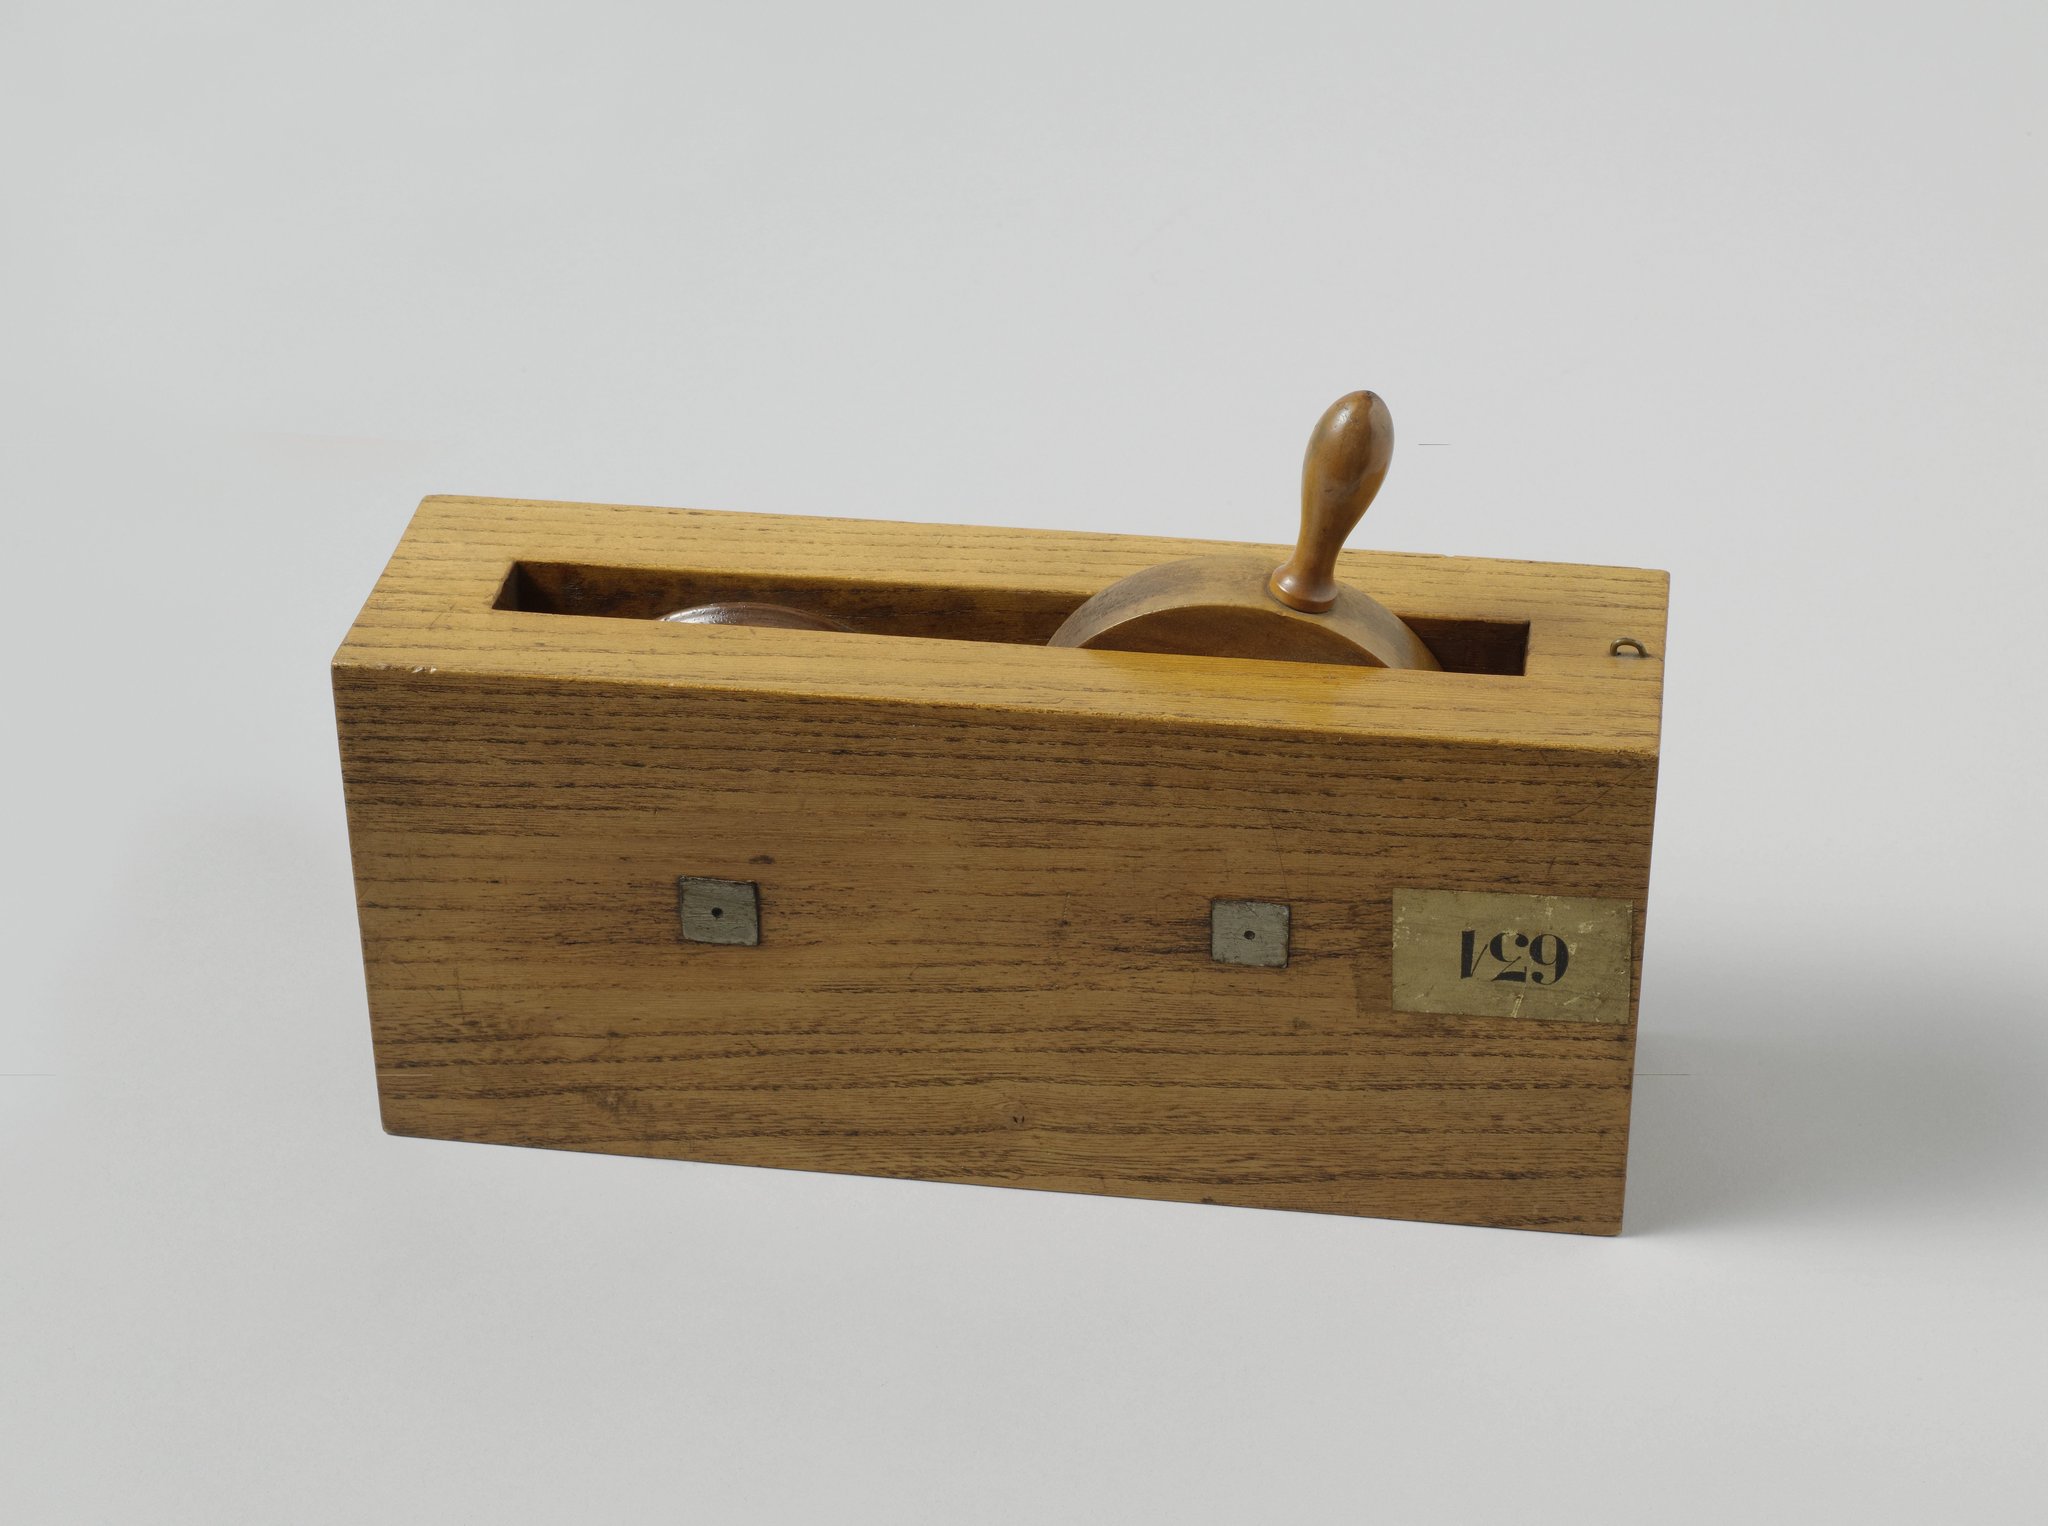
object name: demonstration model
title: Model of an Eccentric Stopper for Sheets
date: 1856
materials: iron, wood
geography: amsterdam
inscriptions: label: ‘631’ former inventory label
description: Model van een excentrieke stopper voor zeilschoten, bestaande uit twee schijven in een houten blok. Een van de schijven is excentrisch en heeft een handvat of korvijnagel. Door de schoot tussen de twee schijven te klemmen, wordt de schoot gestopt.